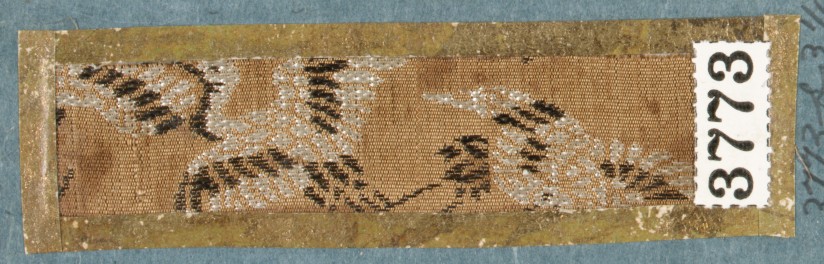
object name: sample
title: Textile Sample from Sample Book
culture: japanese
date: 1801-1900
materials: silk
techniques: tapestry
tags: cranes